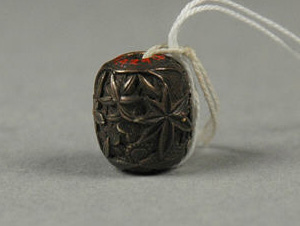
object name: ojime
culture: japanese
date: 1801-1900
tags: leaves